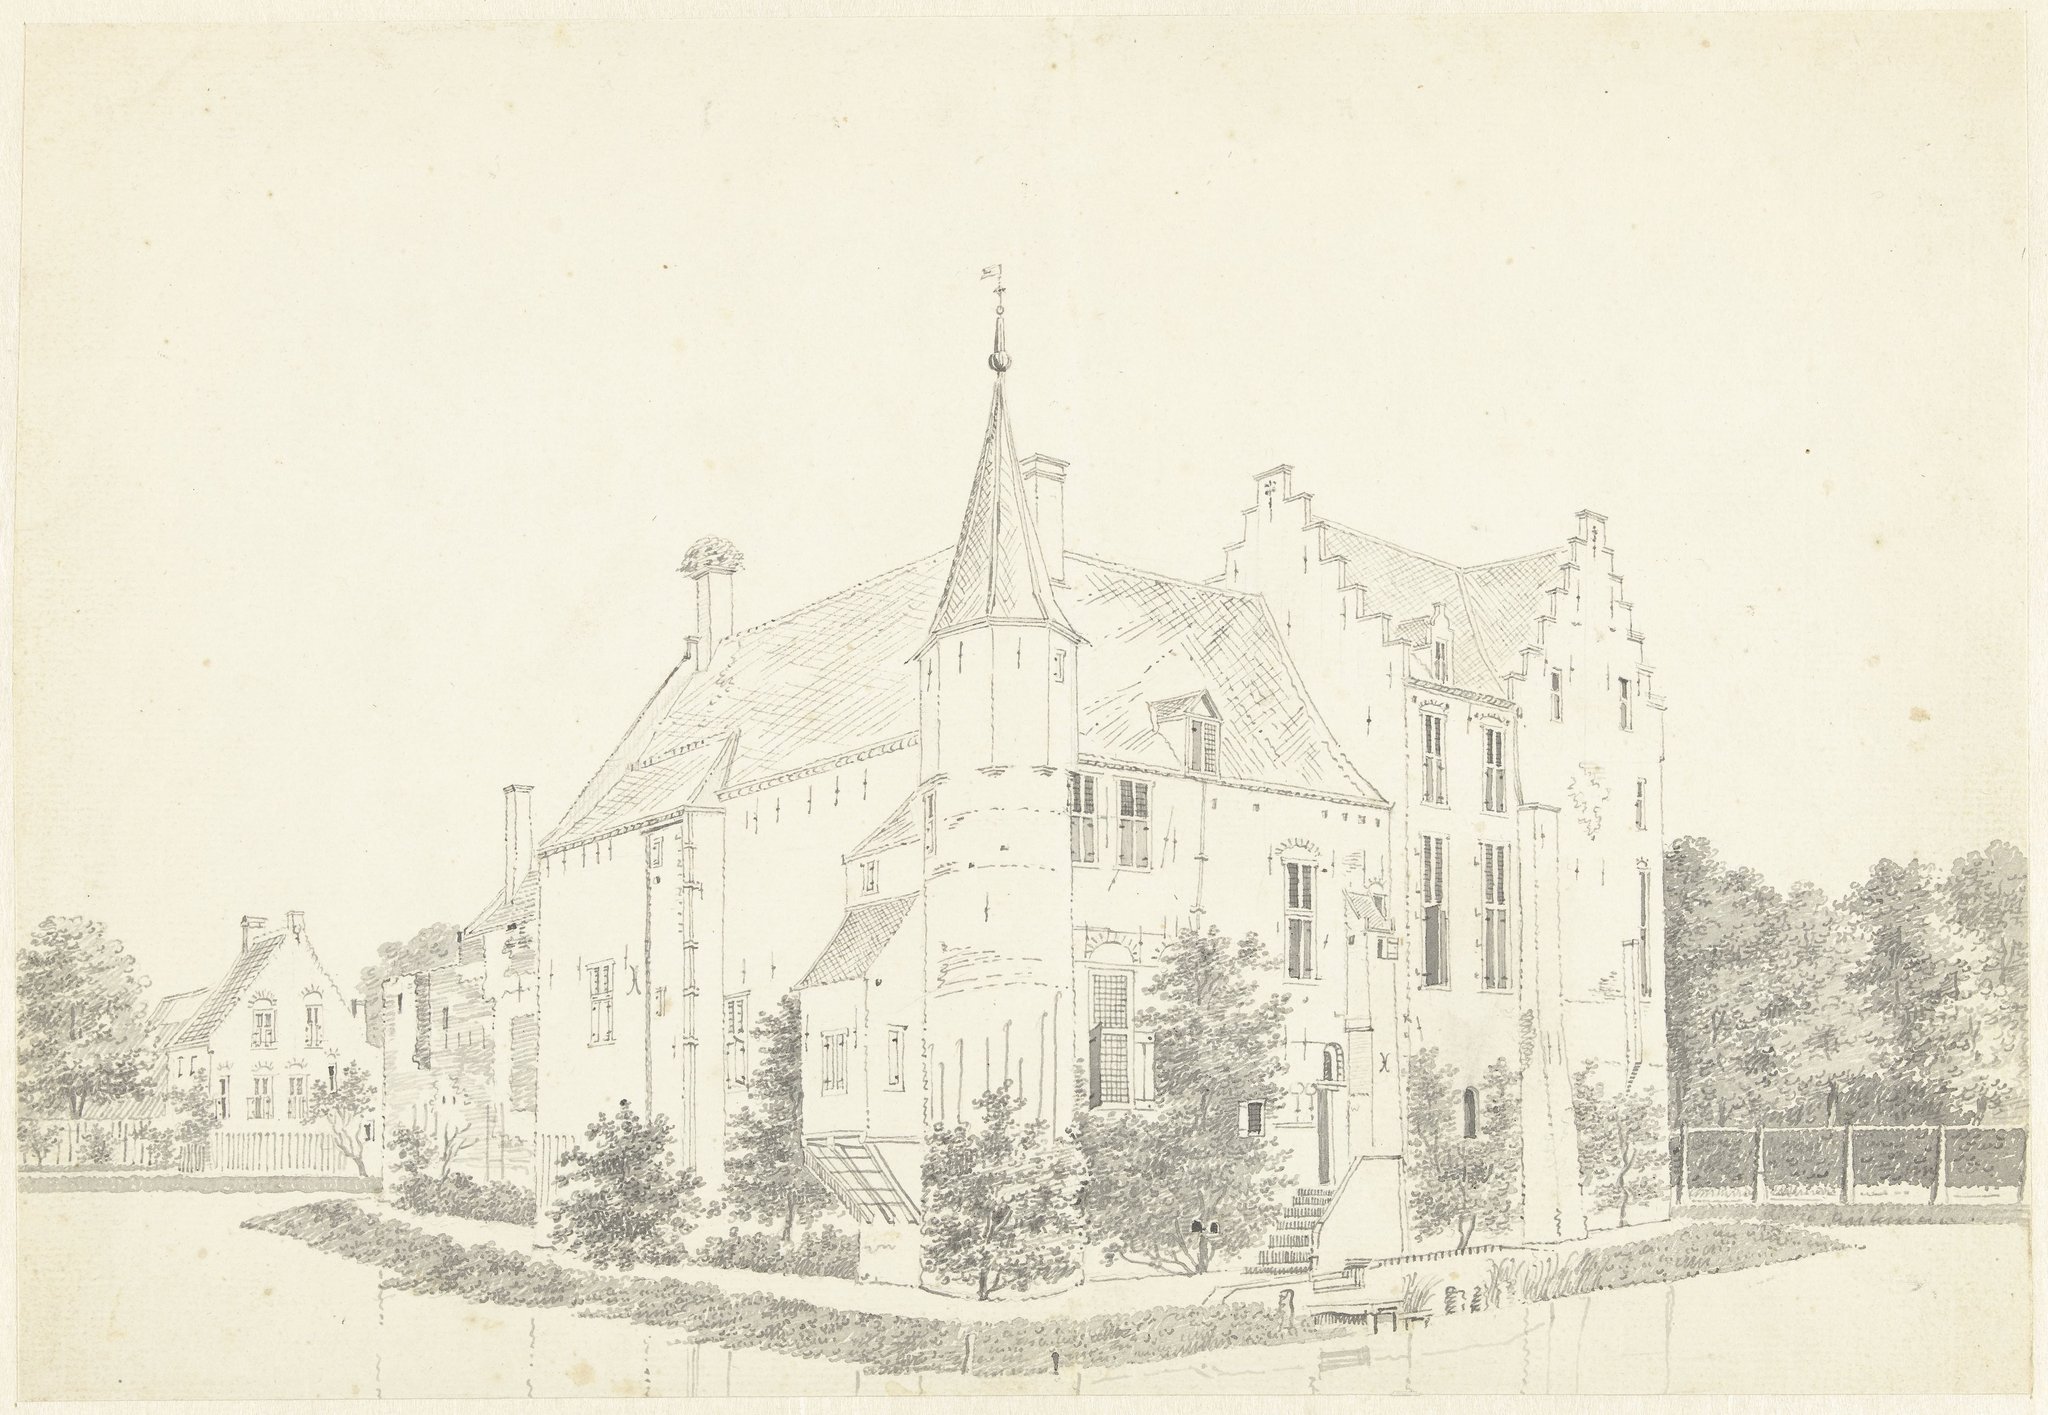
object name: drawing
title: Rijsenburg (Neerlangbroek)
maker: jan de beijer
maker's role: draughtsman, print maker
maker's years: 1703-1780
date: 1751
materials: ink, paper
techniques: brush, pen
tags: castle